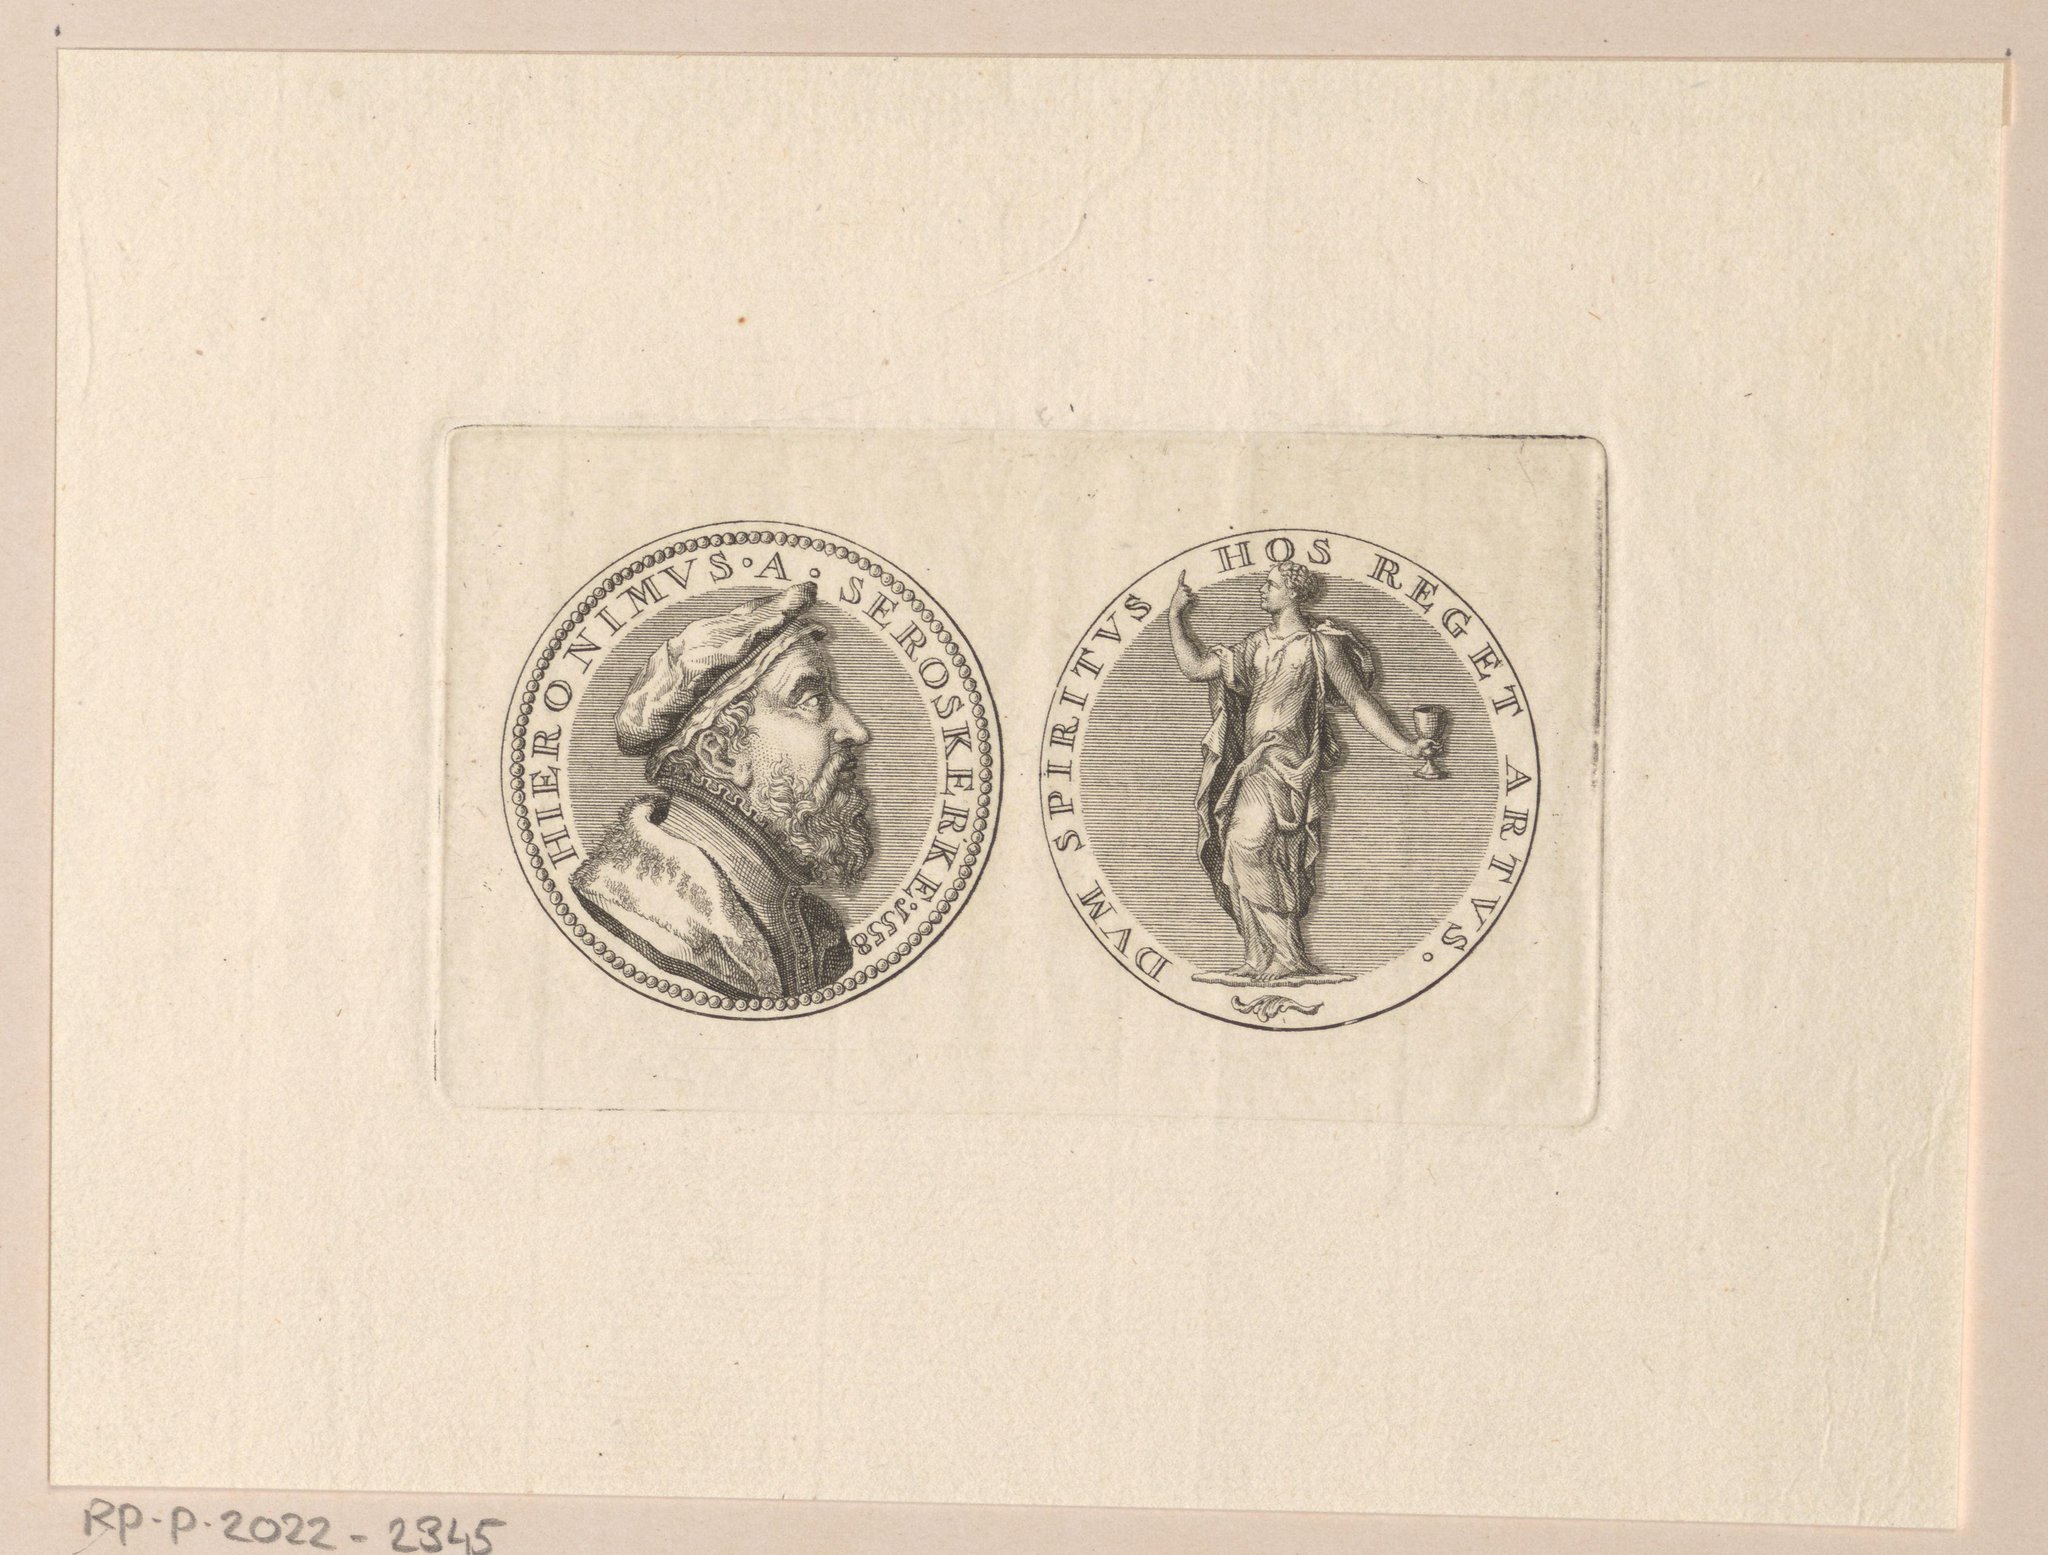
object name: print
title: Voor- en achterzijde van een penning met het portret van Hieronymus Tuyll van Serooskerken.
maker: Anonymous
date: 1723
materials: paper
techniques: etching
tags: historical persons, memorial medal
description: Prent met tekst in boekdruk gebruikt in: Loon, Gerard van. Beschryving der Nederlandsche historipenningen (...). Den Haag: Christiaan van Lom et al, 1723.